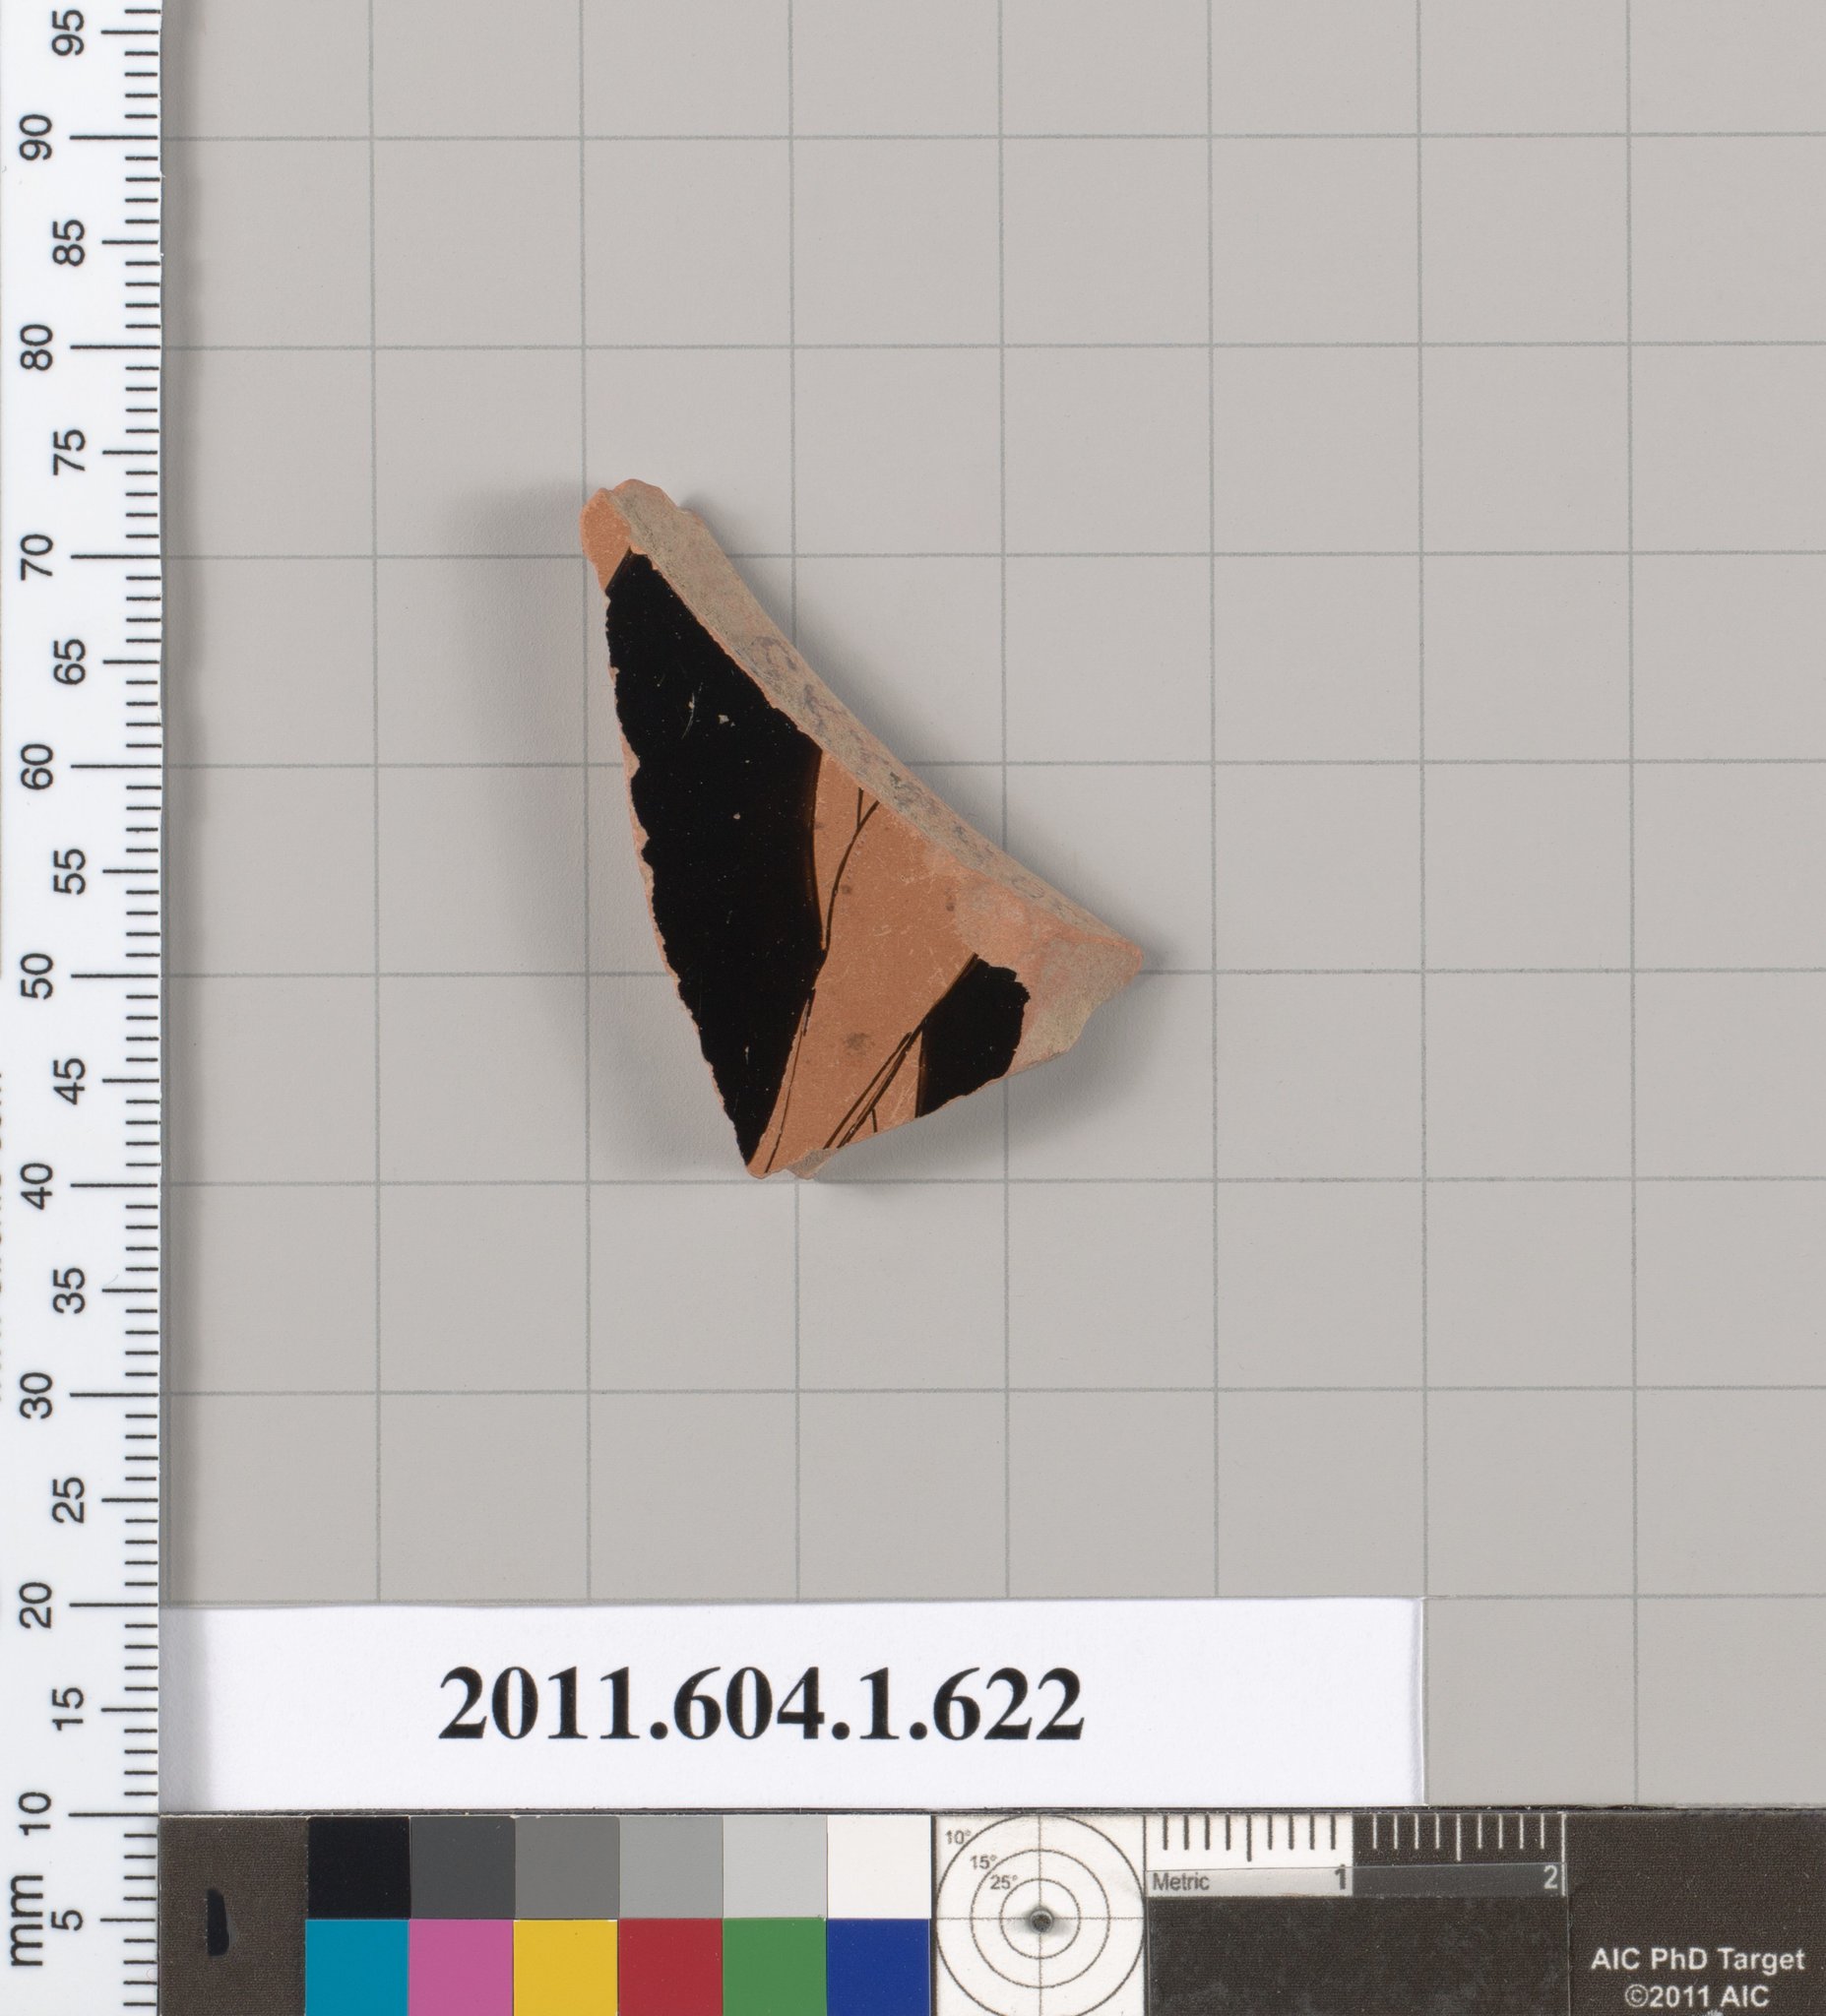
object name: kylix fragment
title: Terracotta fragment of a kylix (drinking cup)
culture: greek, attic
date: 475-451 BCE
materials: terracotta